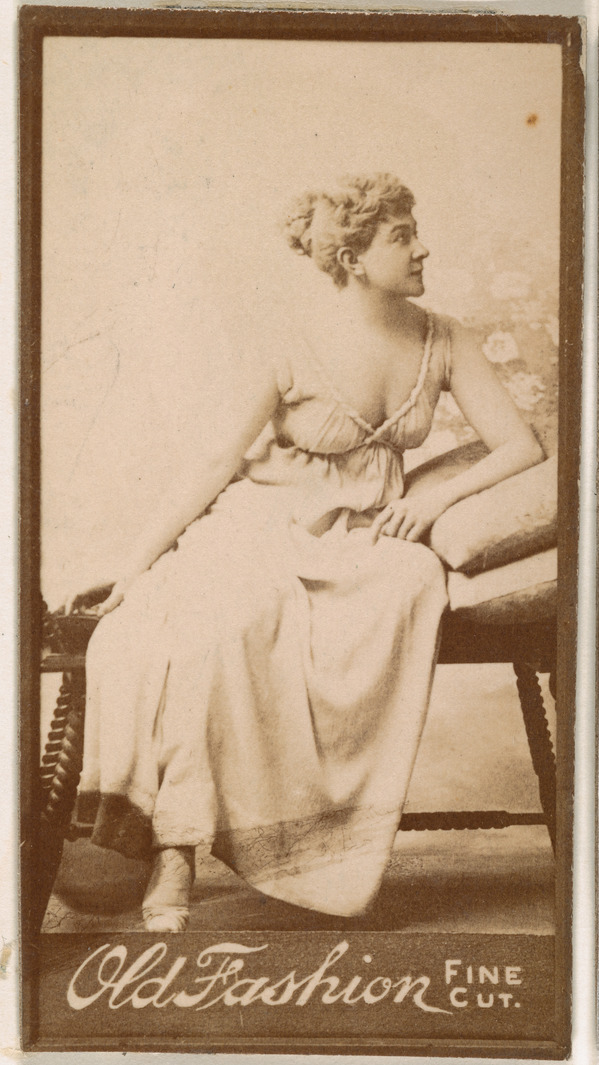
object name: photograph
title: Portrait of actress, from the Actresses series (N664) promoting Old Fashion Fine Cut Tobacco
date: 1888-1890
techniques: albumen silver print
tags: portraits,women,actresses